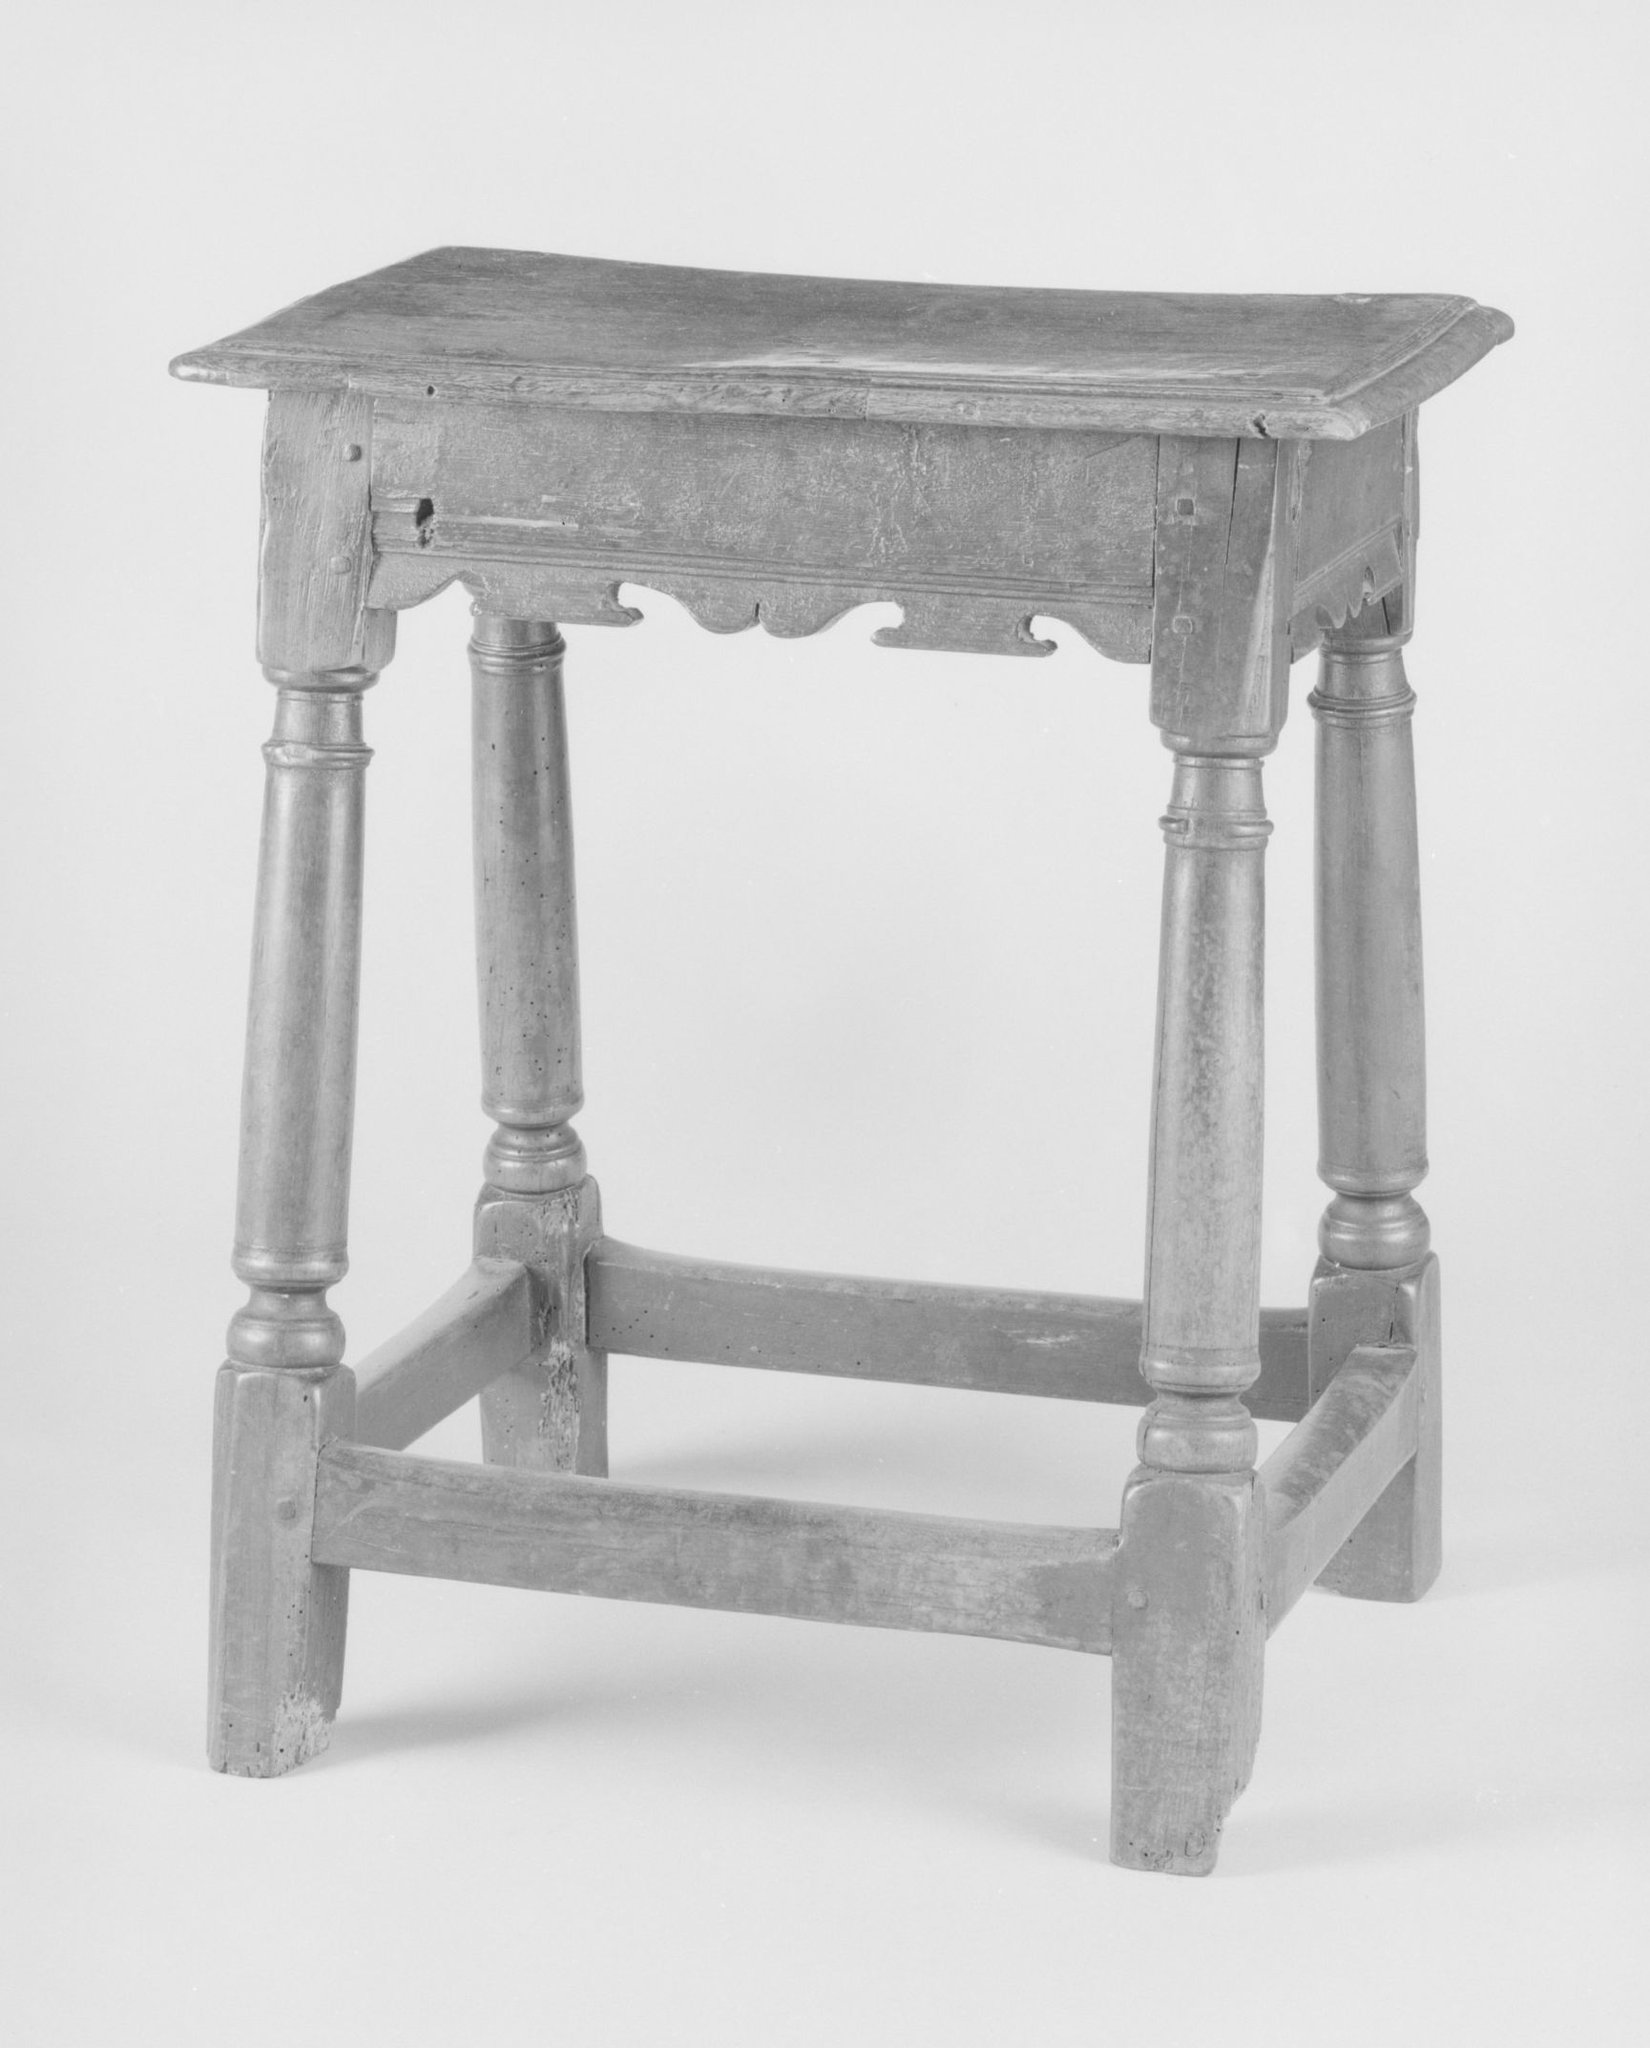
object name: joint stool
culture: british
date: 1650-1700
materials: wood